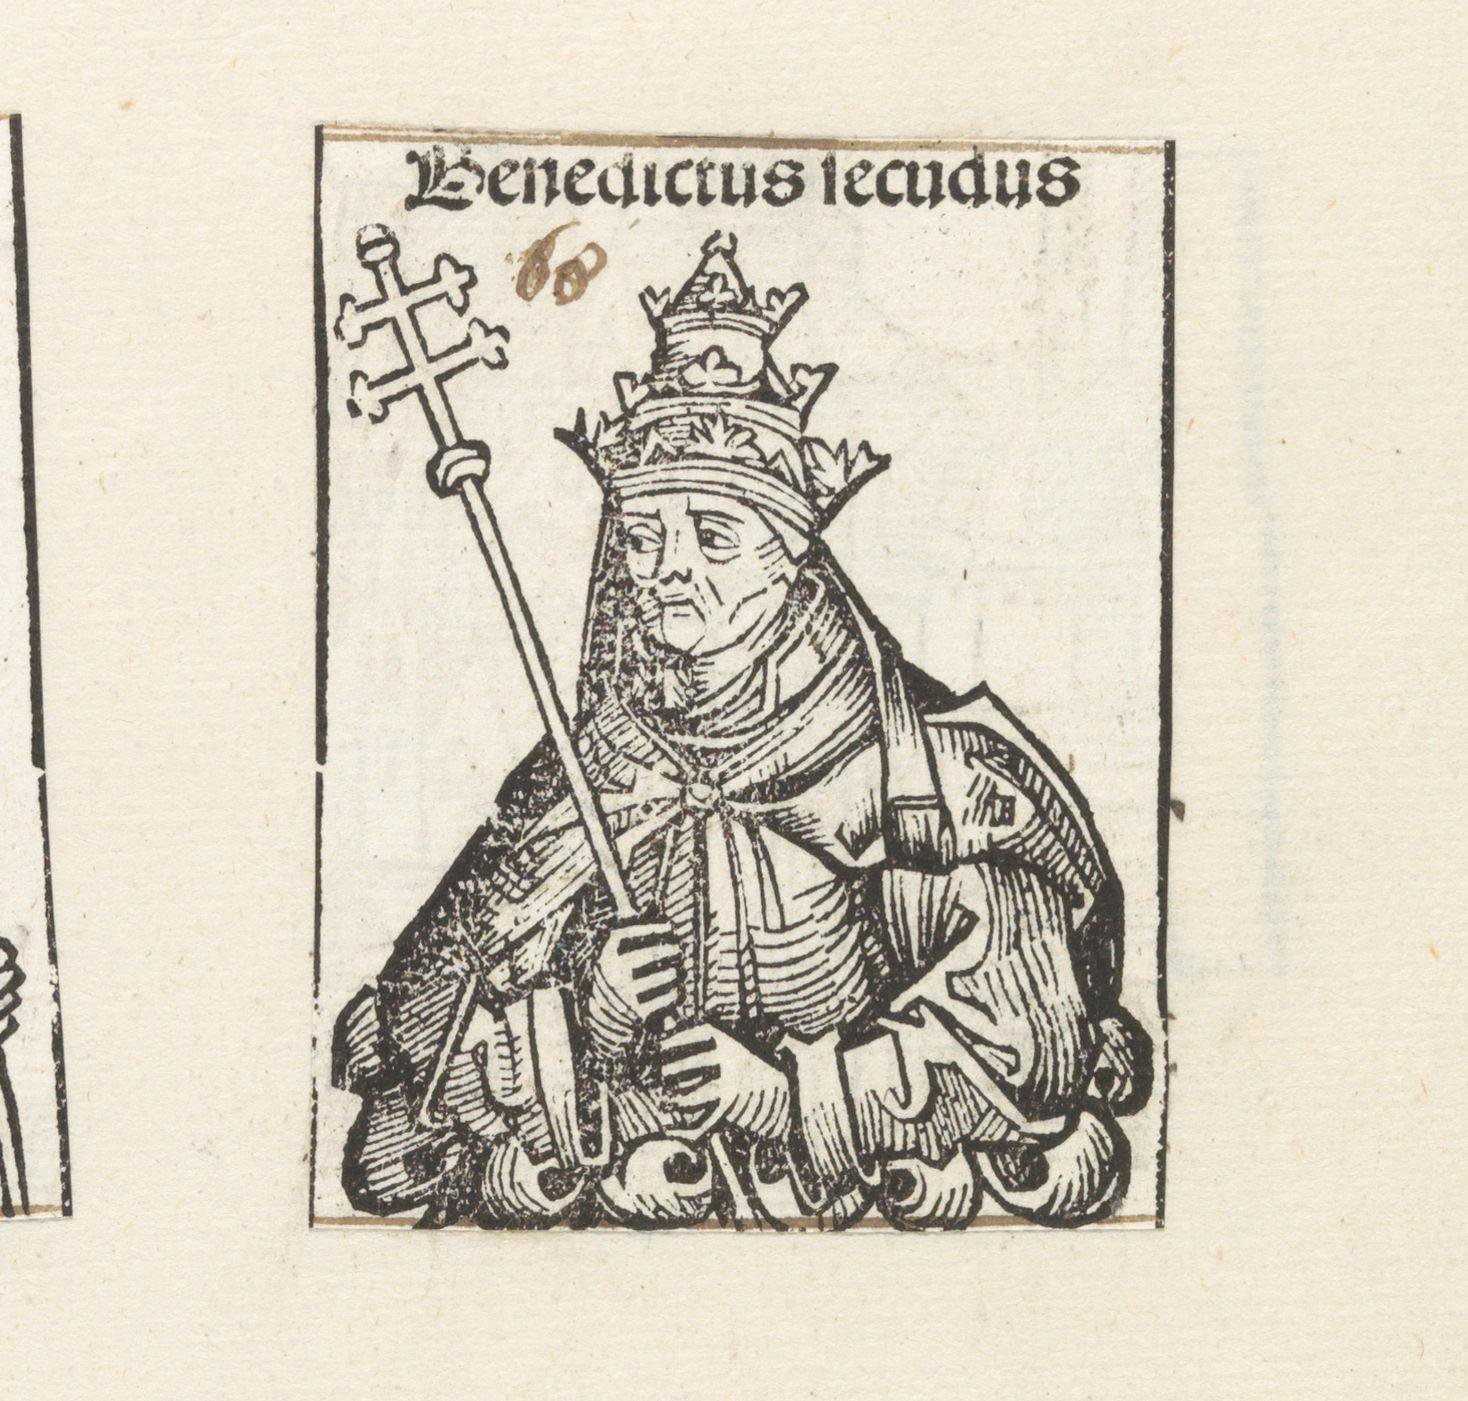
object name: print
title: Liber Chronicarum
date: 1493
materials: paper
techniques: letterpress printing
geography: nuremberg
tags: rome, pope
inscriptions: inscription: ‘68’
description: Een bloemkelk met een paus. Hij draagt een tiara en heeft een staf met een dubbel kruis in zijn handen. De voorstelling is onderdeel van de opeenvolging pausen in de Liber Chronicarum. De tekst identificeert de man als Benedictus II. De prent maakt deel uit van een album.